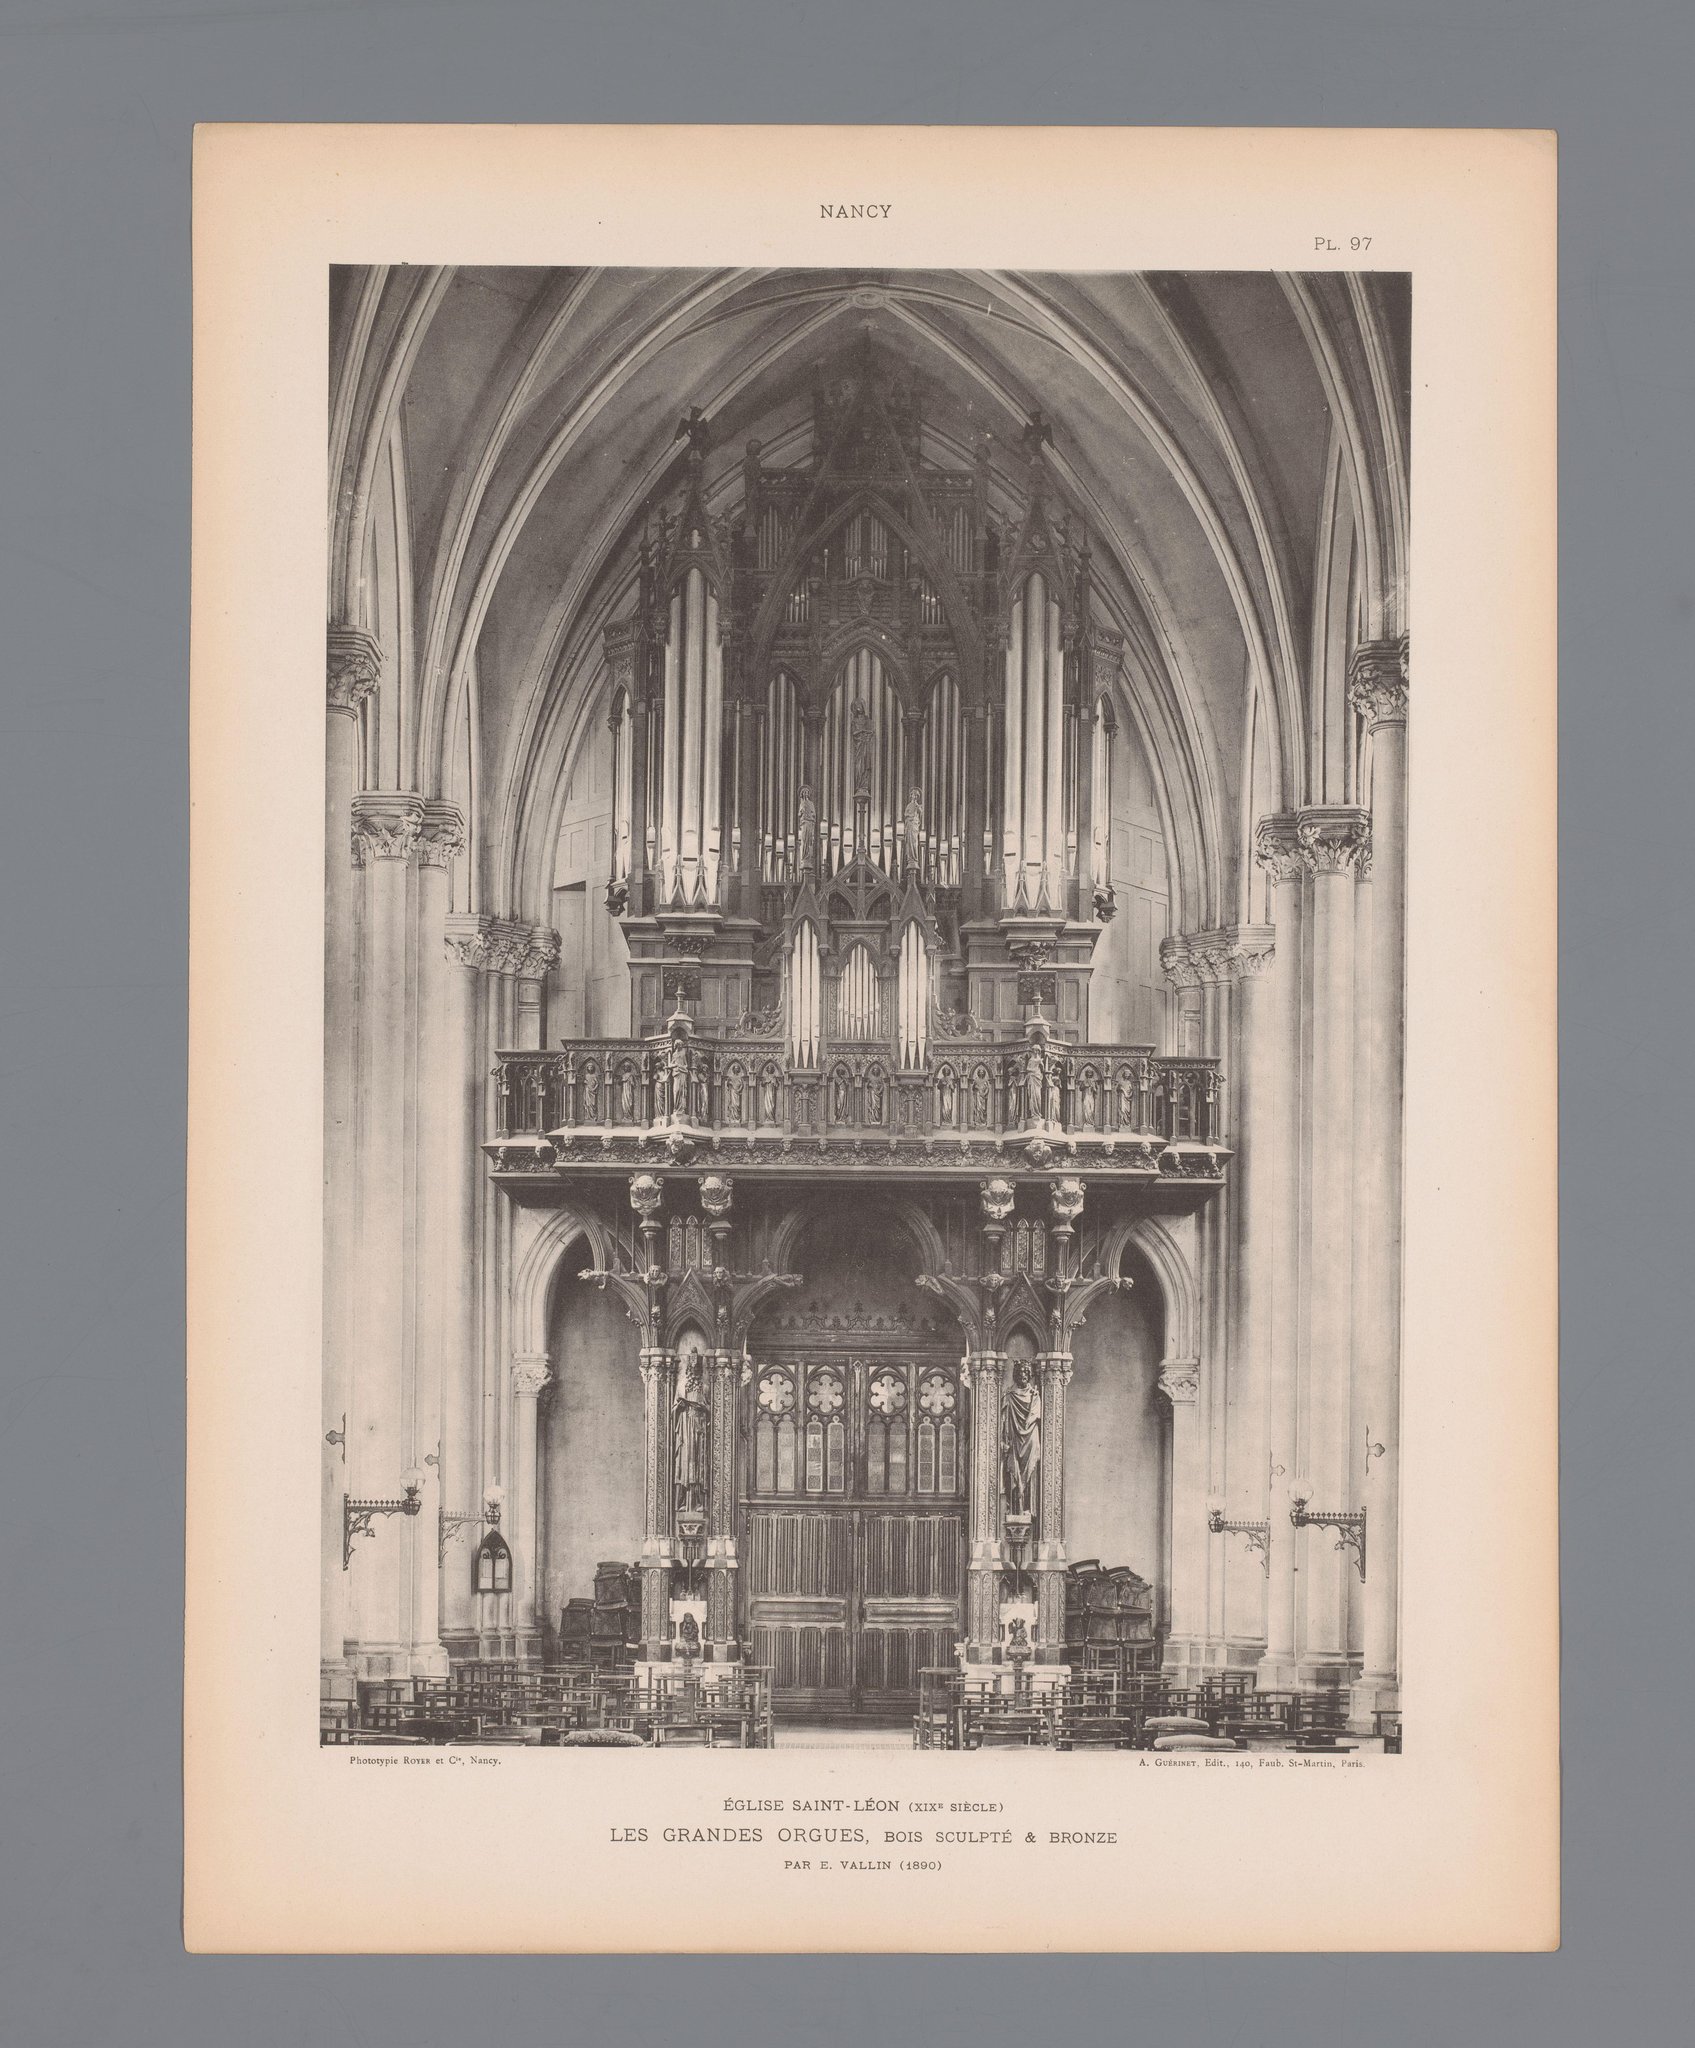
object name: photomechanical print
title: Orgel in de Église Saint-Léon te Nancy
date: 1891-1896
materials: paper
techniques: photograph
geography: nancy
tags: church organ, interior of church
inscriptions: inscription: ‘Église Saint-Léon (XIXe siècle)/ Les grandes orgues, bois sculpté & bronze/ par E. Vallin (1890)’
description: Deze prent maakt deel uit van een omslag met 103 prenten op 101 bladen en een titelblad.